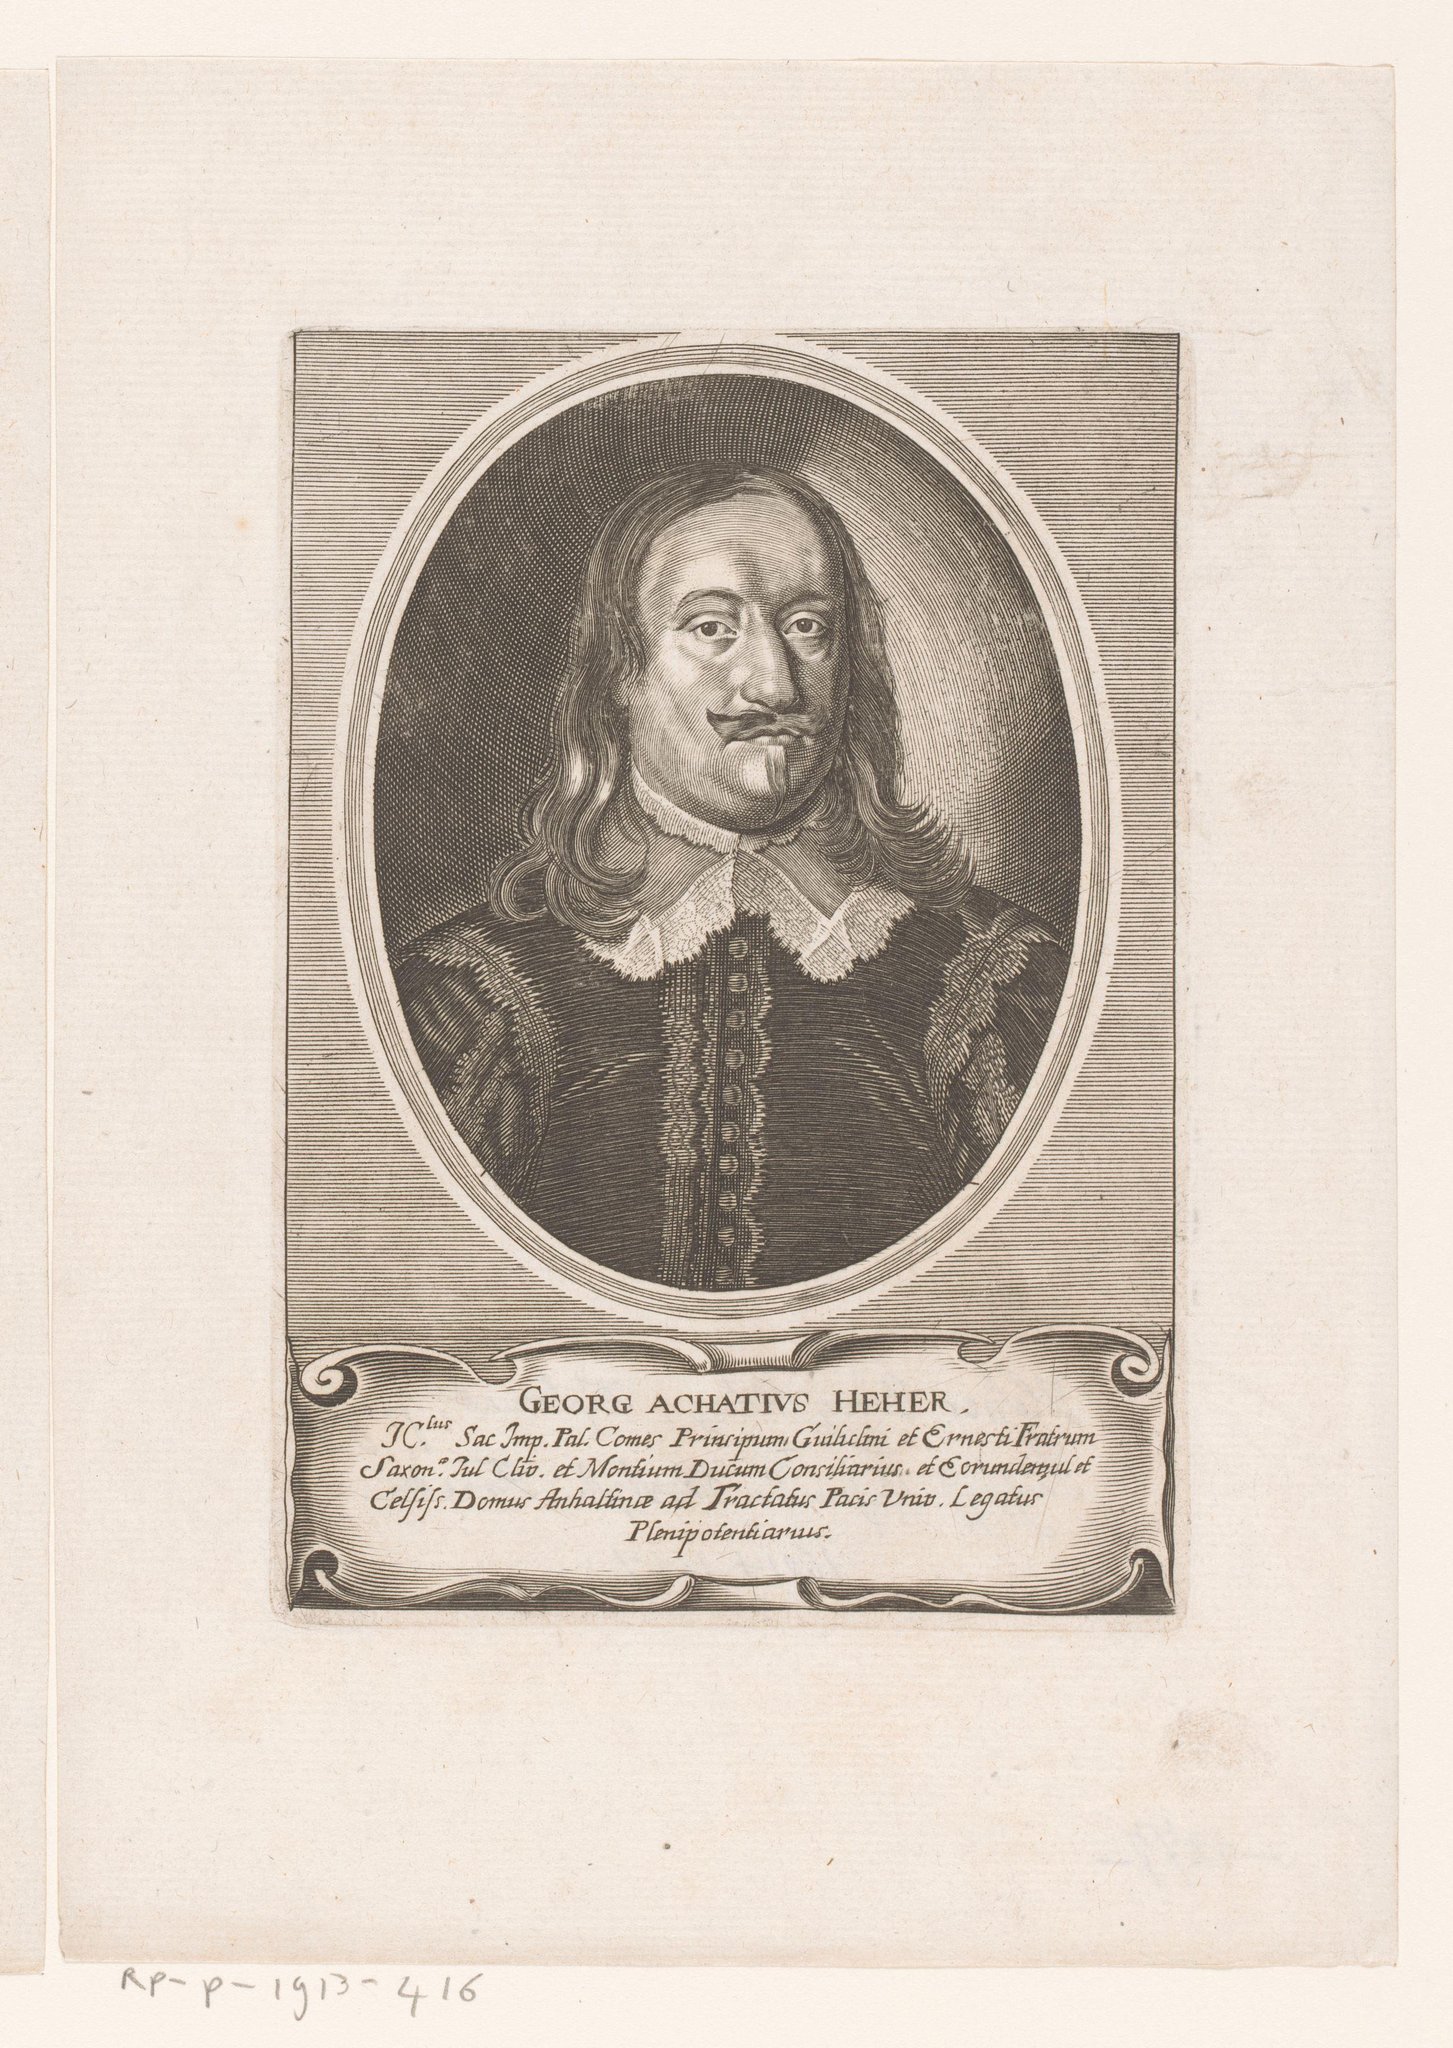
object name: book illustration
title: Portret van Georg Achaz Heher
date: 1652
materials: paper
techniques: engraving, etching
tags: historical persons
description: Illustratie in: J.G. Schleder. Theatrum Europaeum. Dl. 6. Frankfurt a.M., Merian, 1652. P. 926.